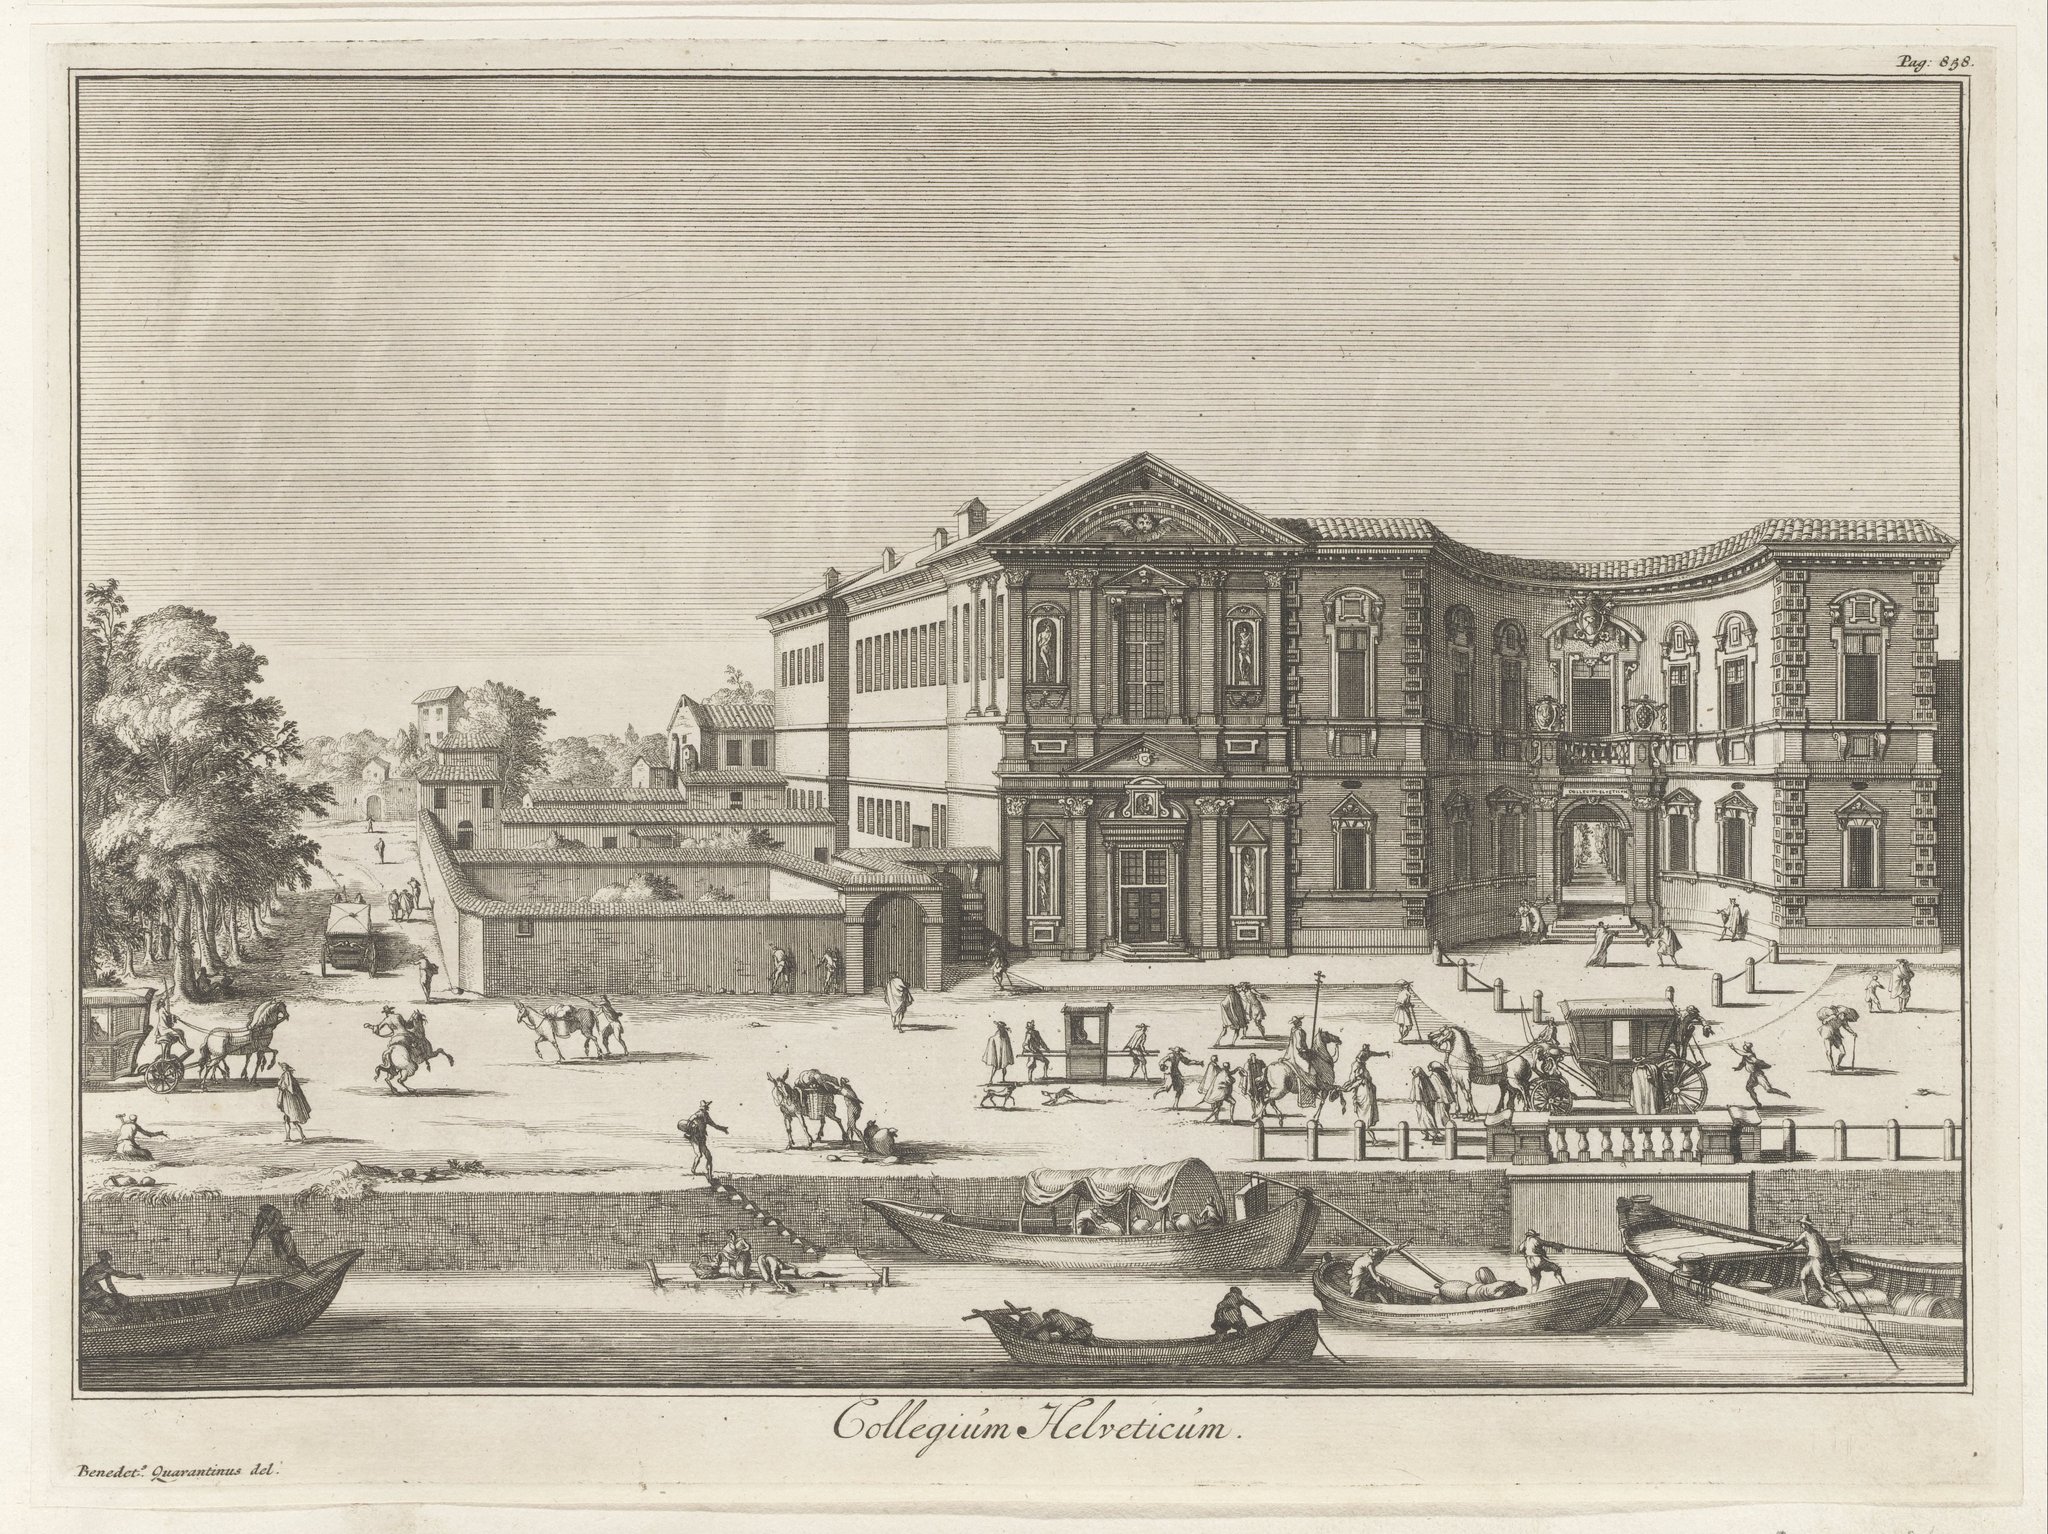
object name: album leaf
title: Collegio Helvetia te Milaan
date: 1704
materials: paper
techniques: etching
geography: leiden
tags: city-view, and landscape with man-made constructions, university building, college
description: Prent uit: Giovanni Giorgio Grevio, Thesaurus Antiquitatum et Historiarum Italiae, Leiden: Pieter van der AA, 1704.